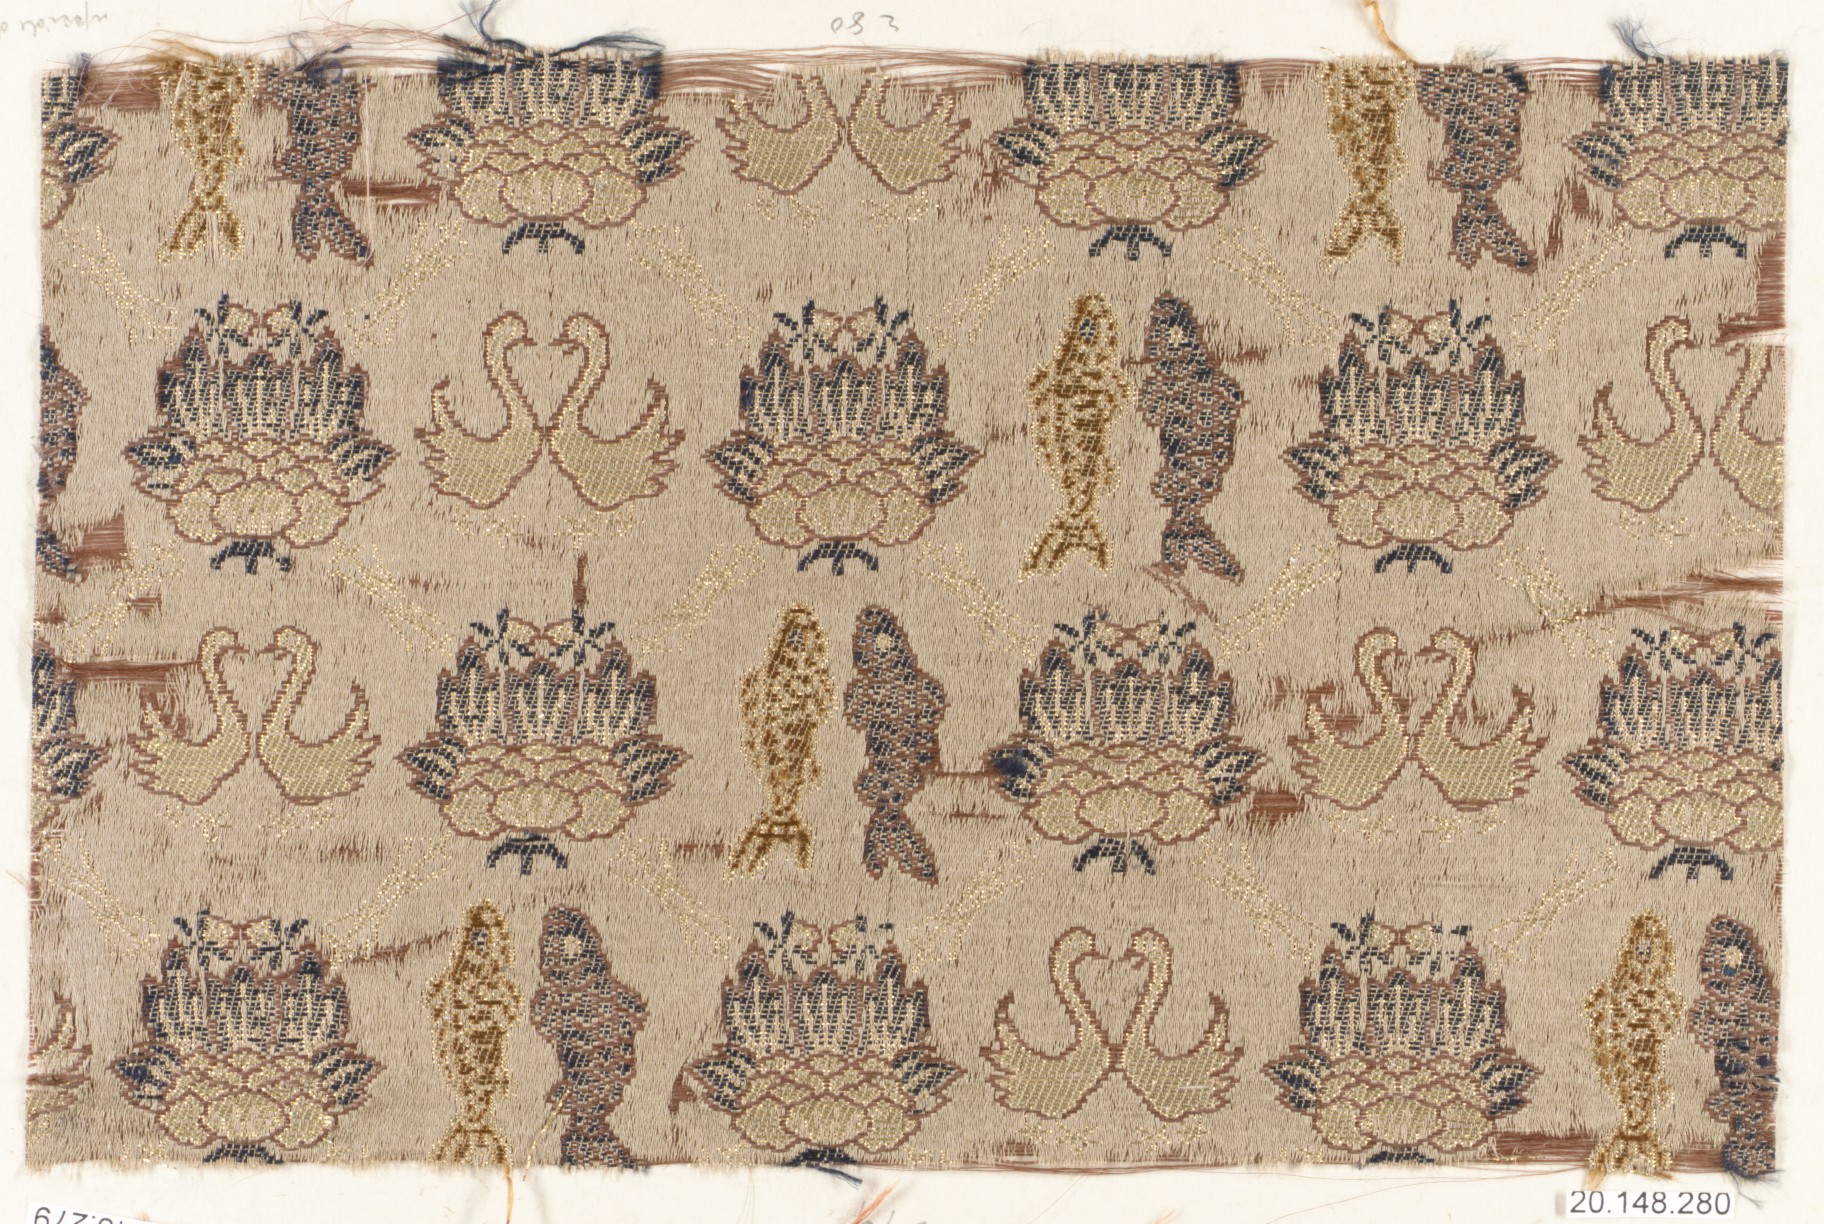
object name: piece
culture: japanese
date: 1701-1800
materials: silk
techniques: compound weave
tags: swans,fish,flowers